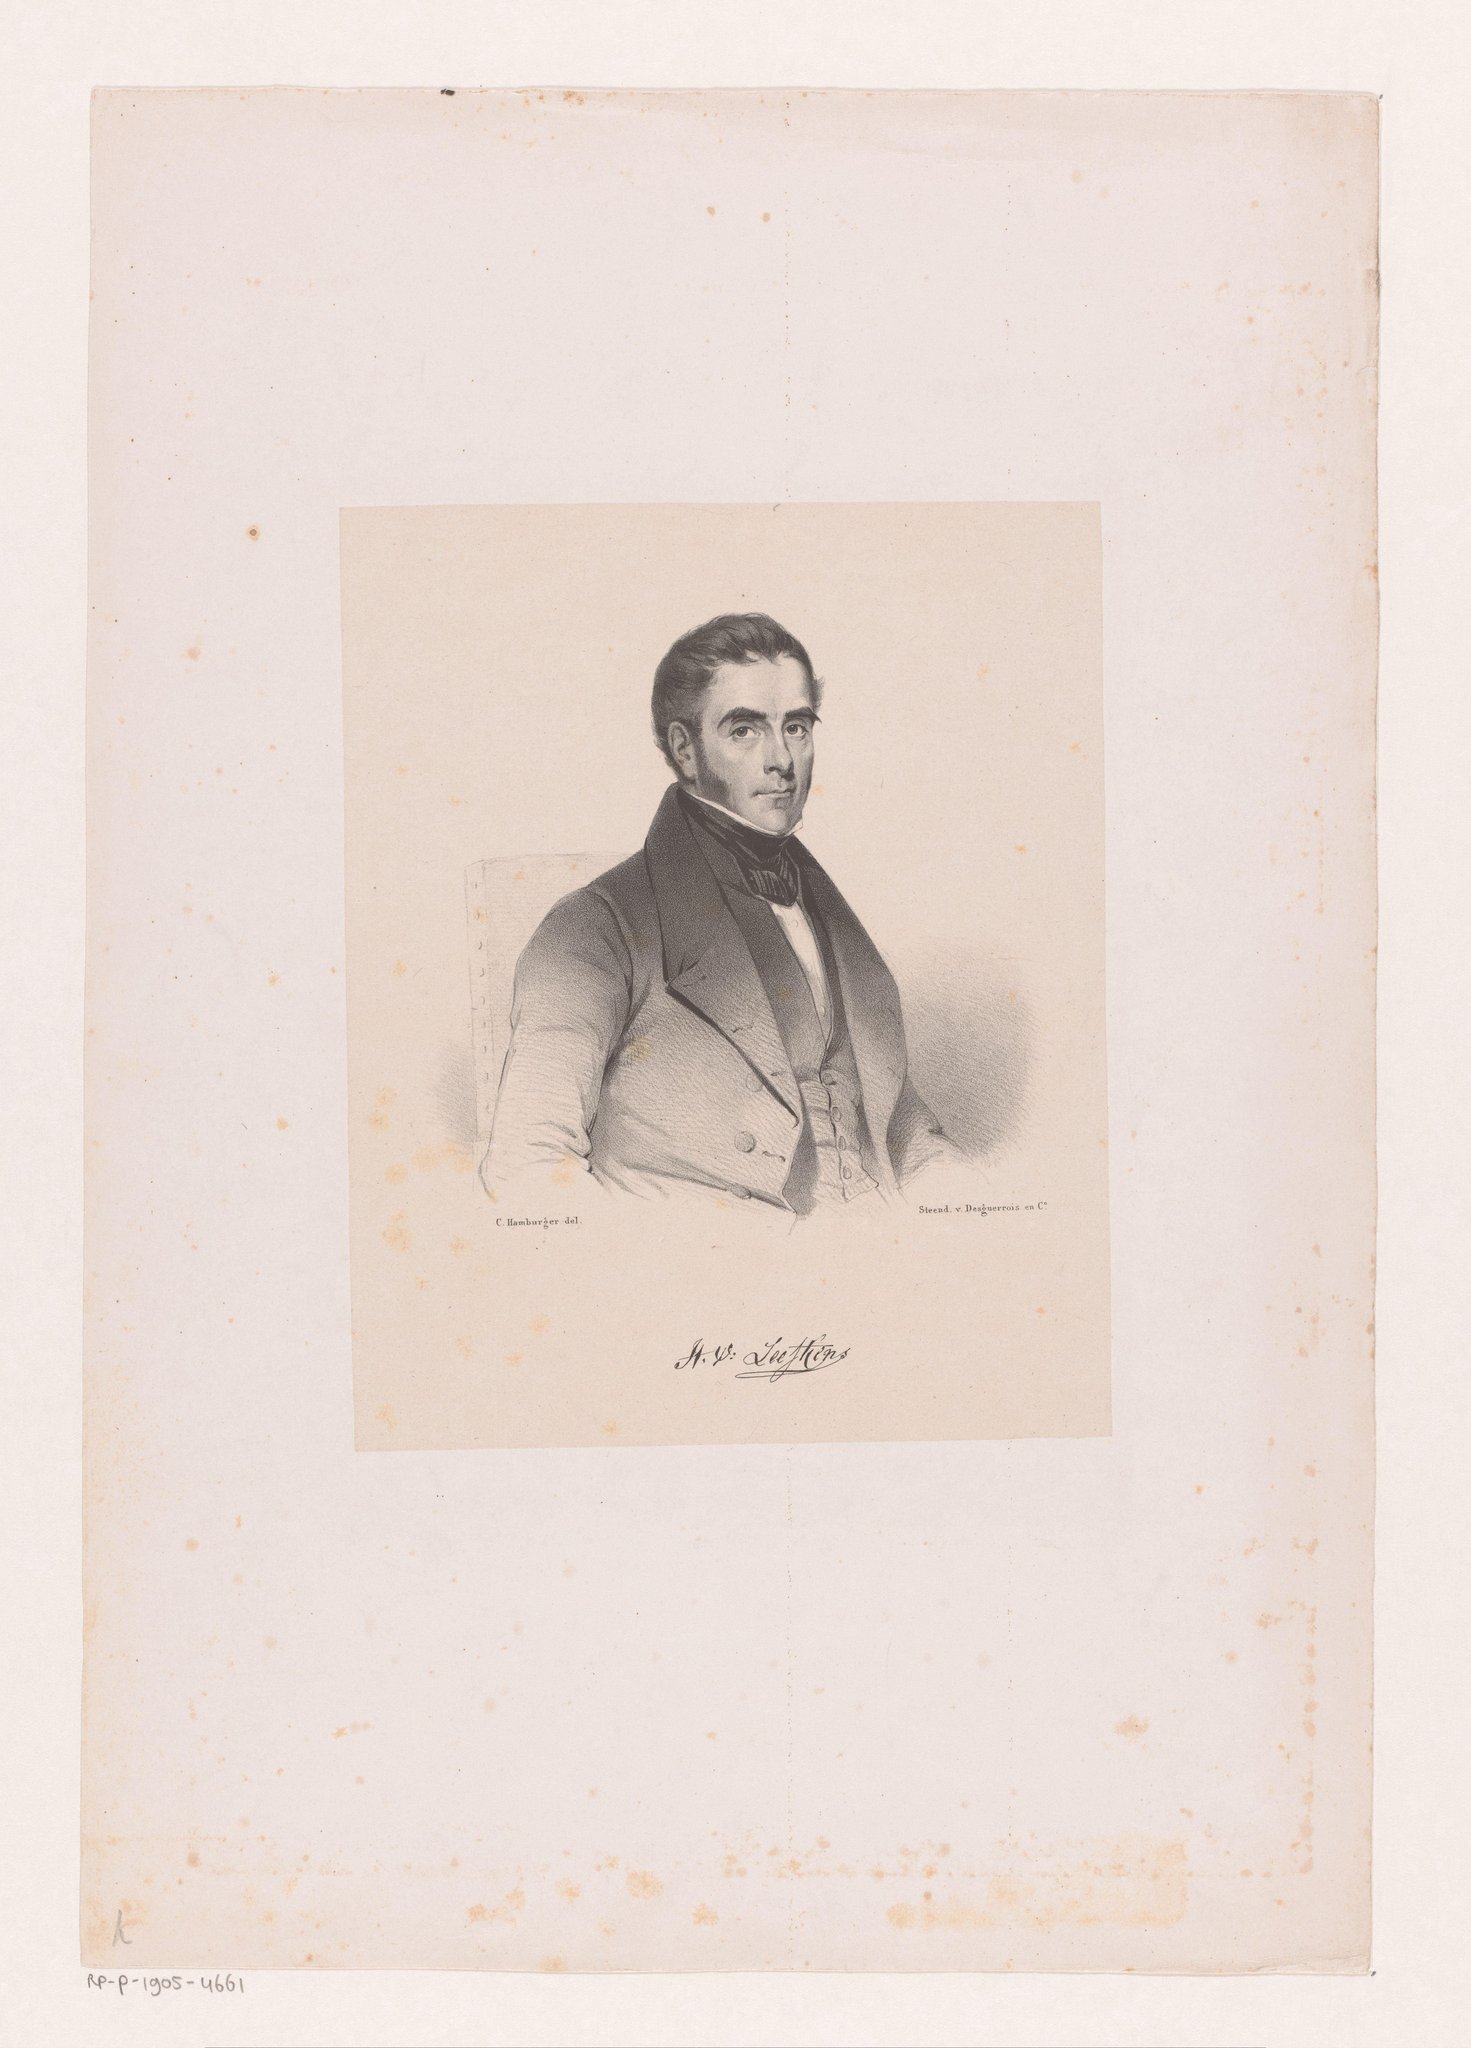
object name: print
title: Portret van H.W. Leefkens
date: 1819-1891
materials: paper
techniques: lithograph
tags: historical persons (+ half-length portrait)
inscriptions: collector's mark: Lugt 2228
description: Onder het portret de signatuur van de geportretteerde.